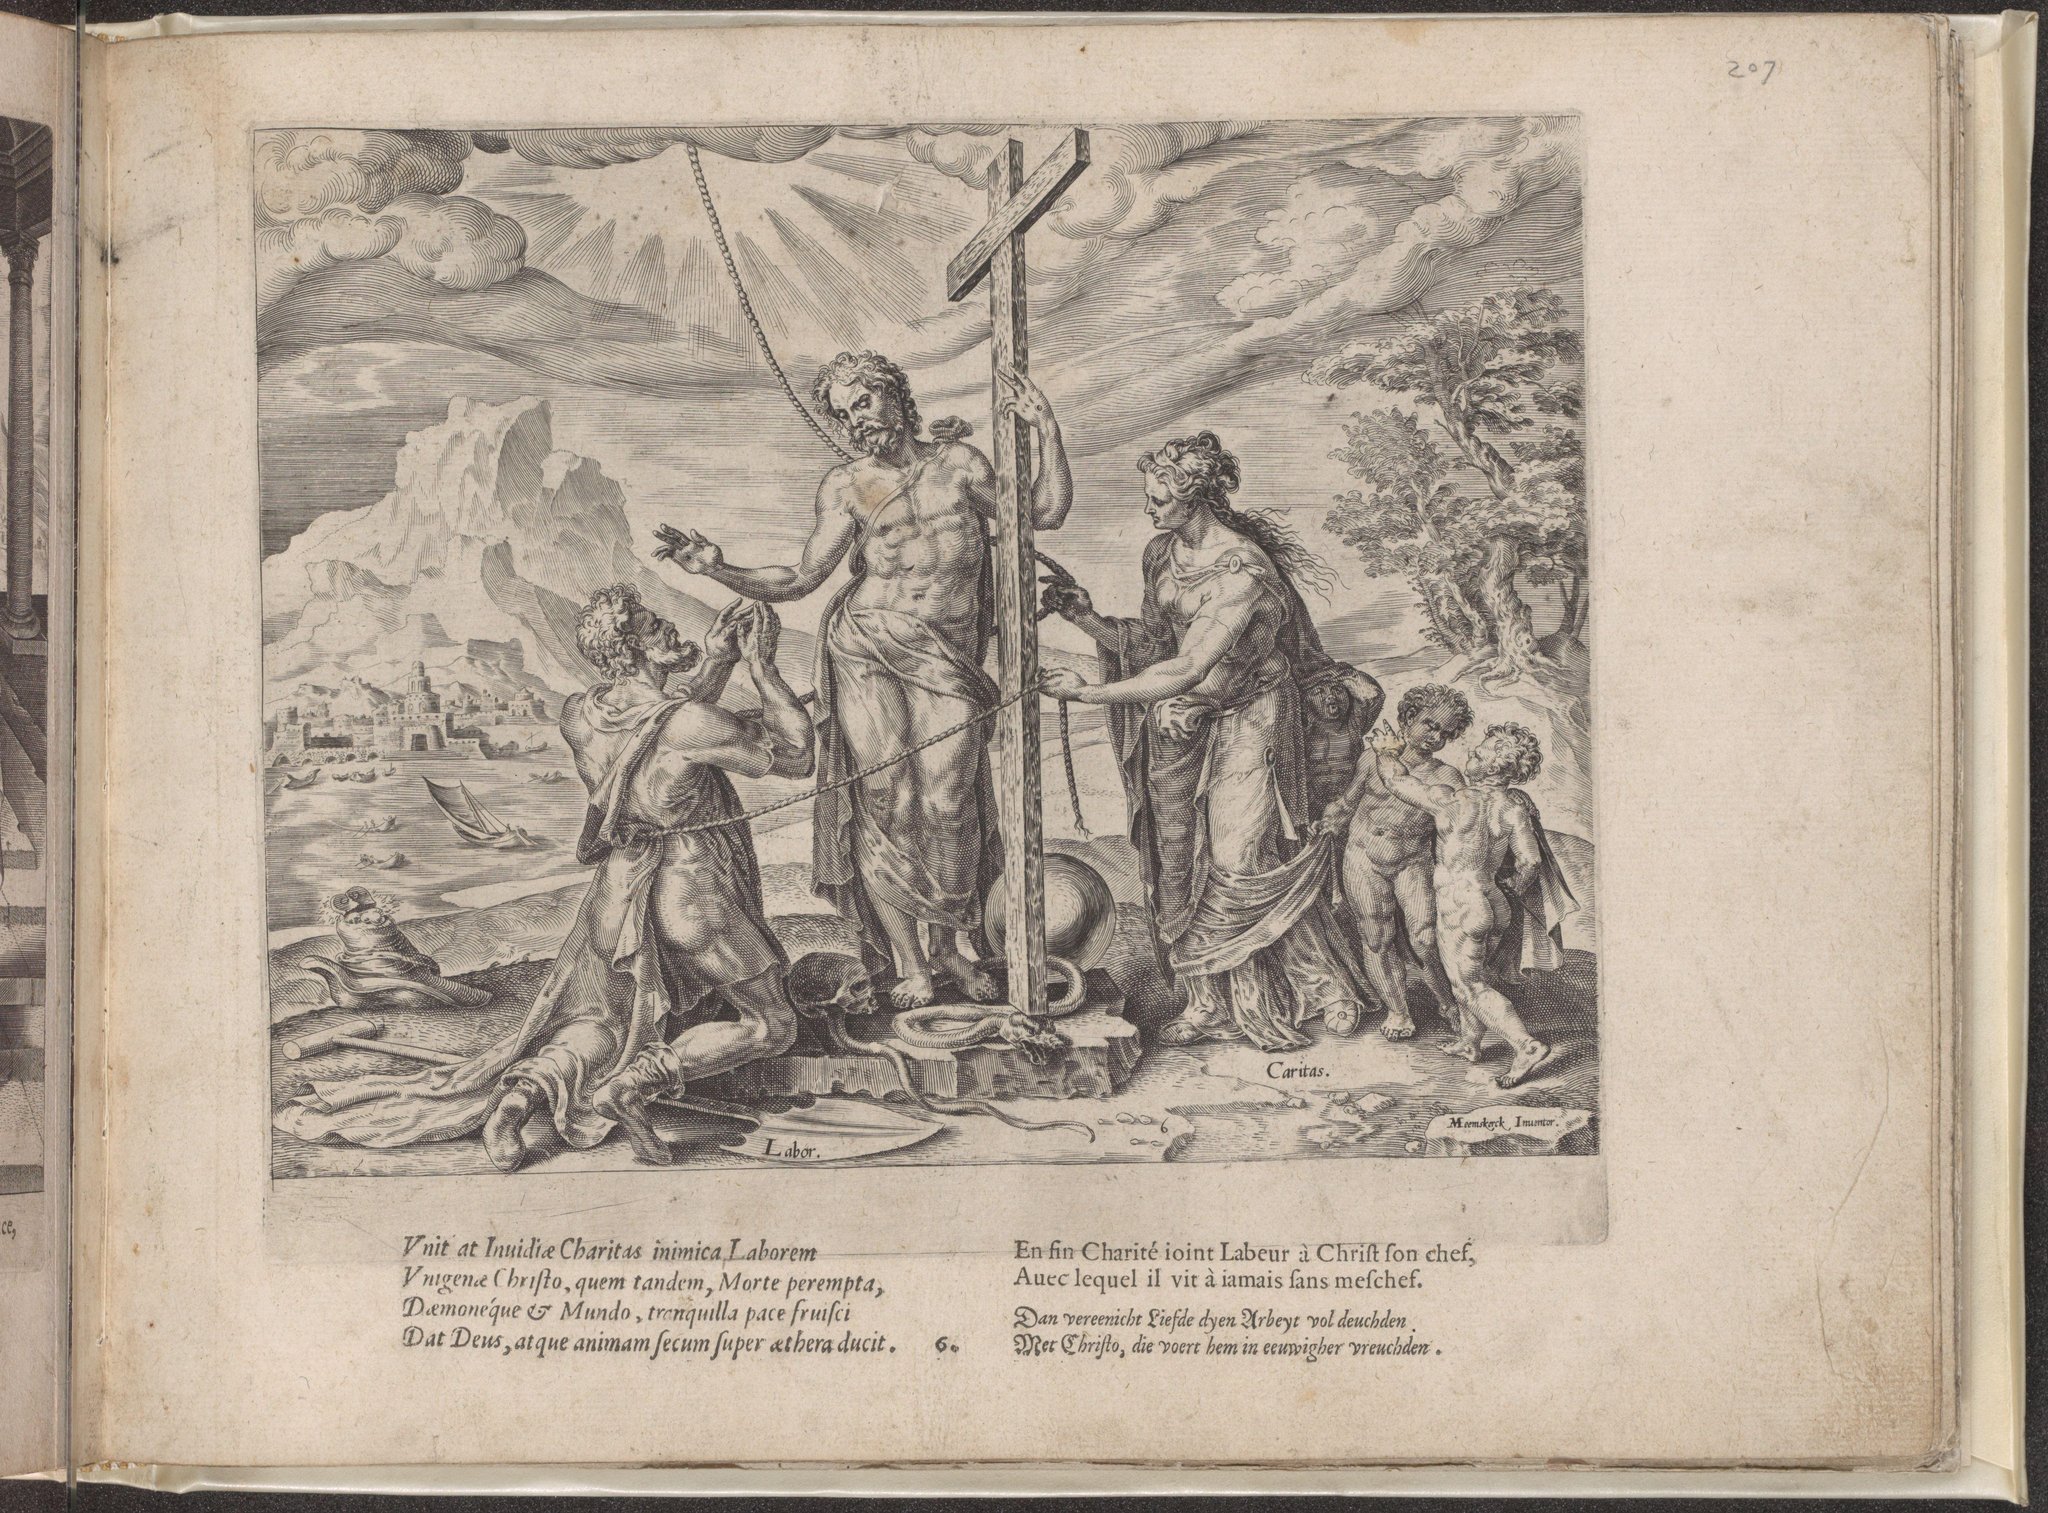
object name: album leaf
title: Arbeid na zijn dood verenigd met Christus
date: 1572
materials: paper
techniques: engraving, letterpress printing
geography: antwerp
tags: charity, 'caritas'; 'carità' (ripa) ~ one of the three theological virtues, christ as adult, labour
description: De personificatie van Arbeid (Labor) knielt voor Christus. De personificatie van Liefde (Caritas) verbindt de twee door middel van een koord dat uit de hemel komt. Onder de voorstelling een vierregelig vers in het Latijn en twee verzen in het Frans en Nederlands in boekdruk. Deze prent maakt deel uit van een album.